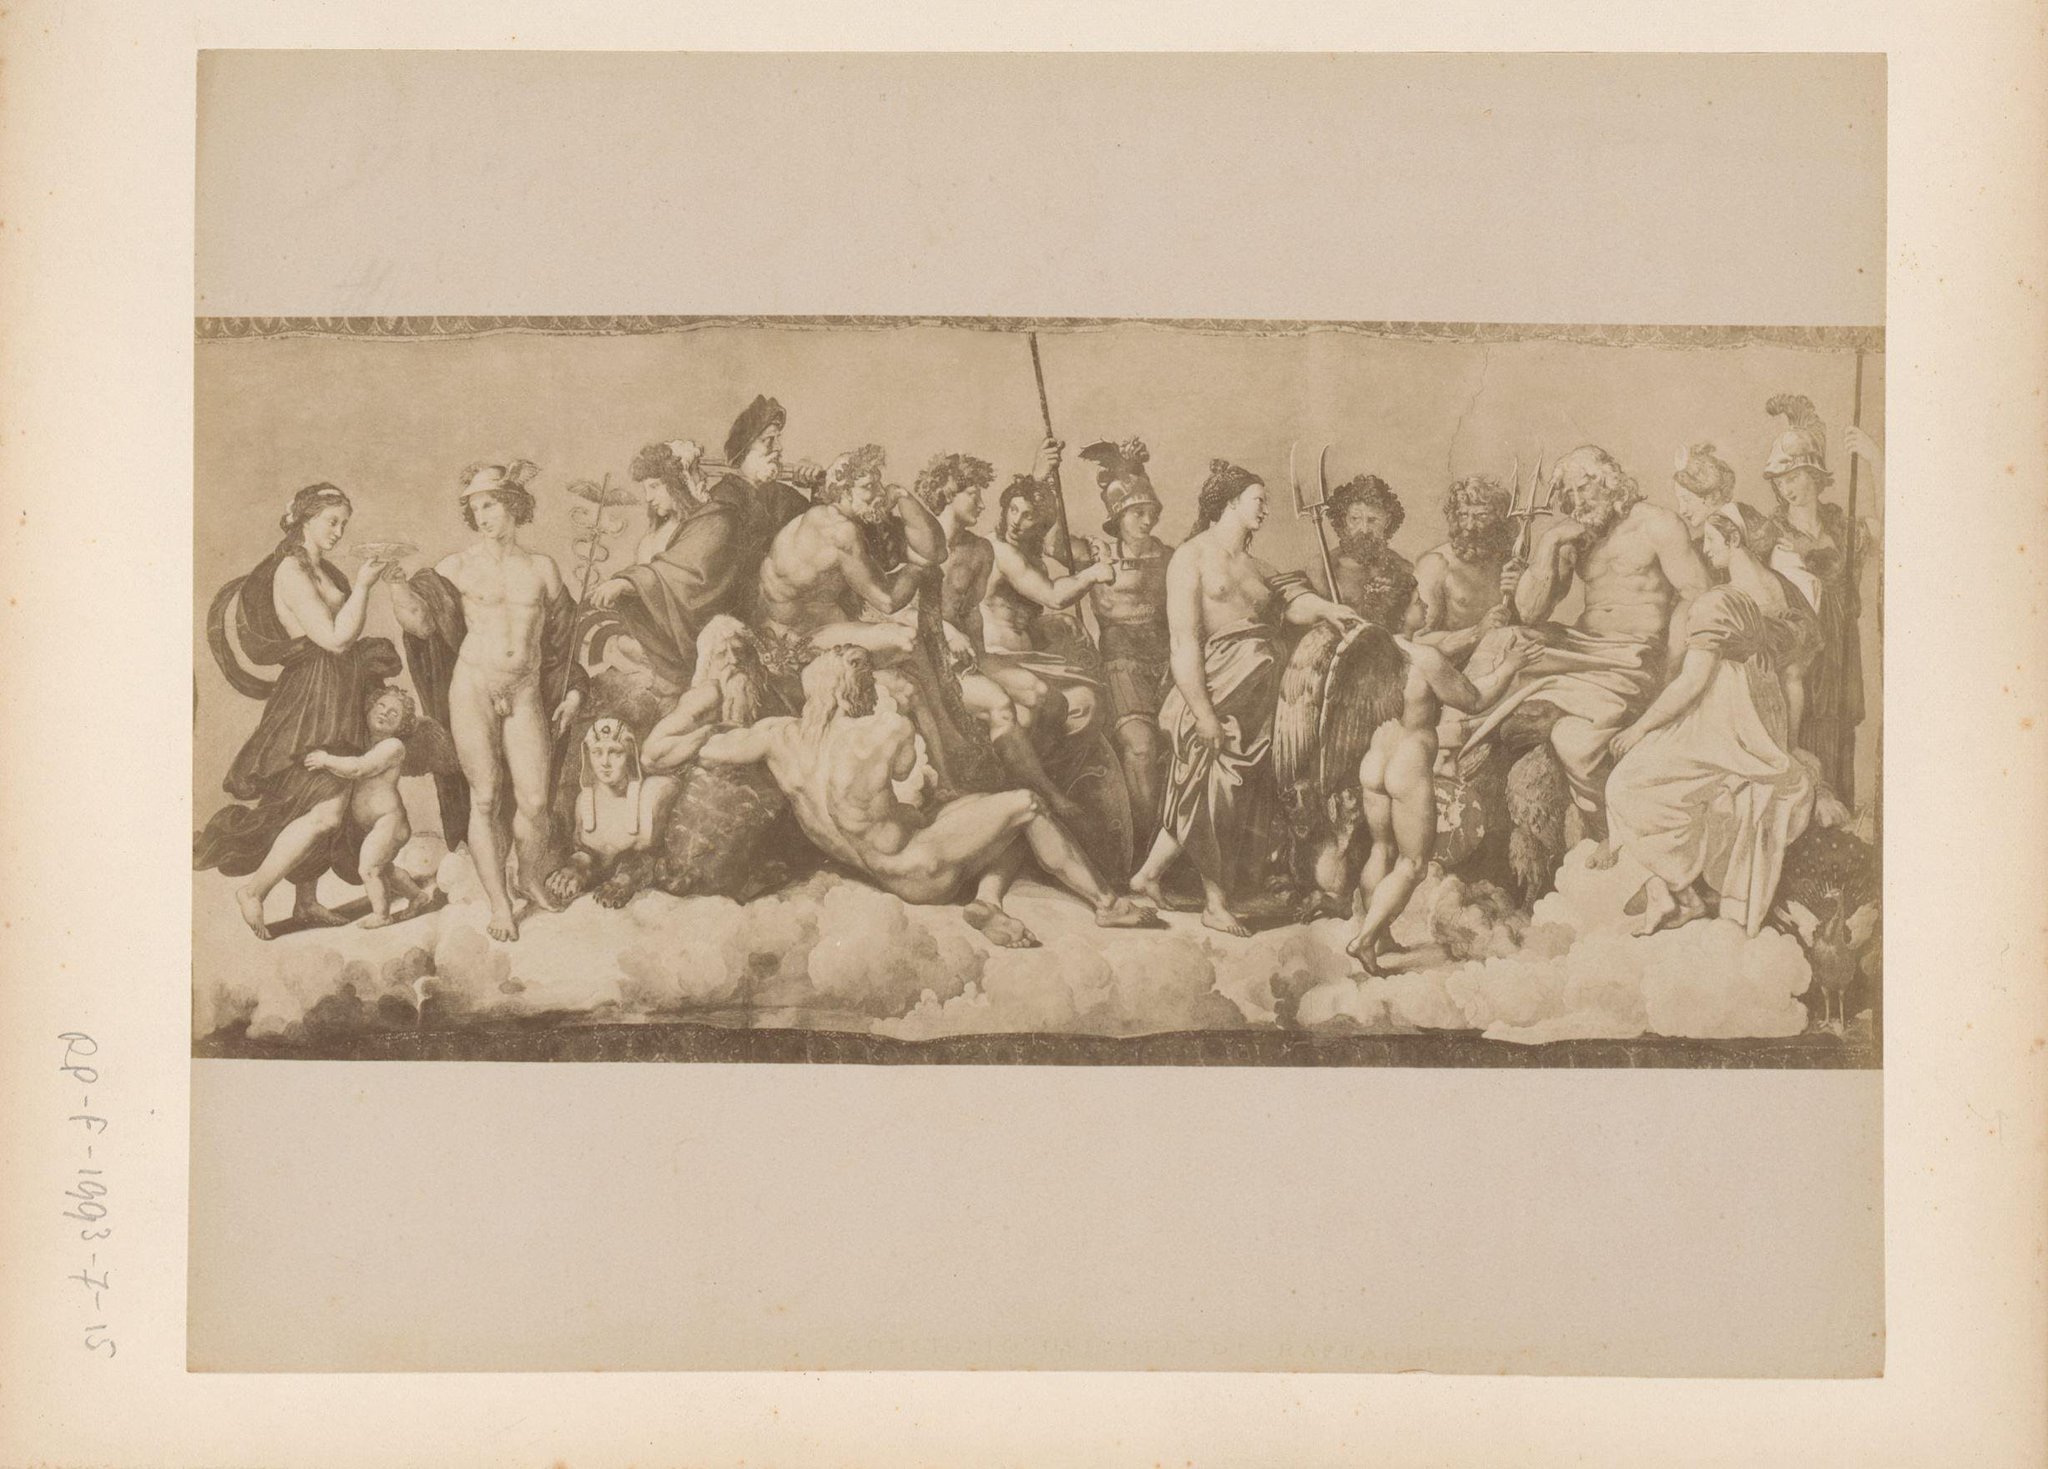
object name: album leaf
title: Fotoreproductie van fresco Het beraad der goden door Rafaël in het Farnesina te Rome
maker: domenico anderson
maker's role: fotograaf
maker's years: 1854-1939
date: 1870-1890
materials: paper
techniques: albumen print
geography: villa farnesina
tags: picture, painting